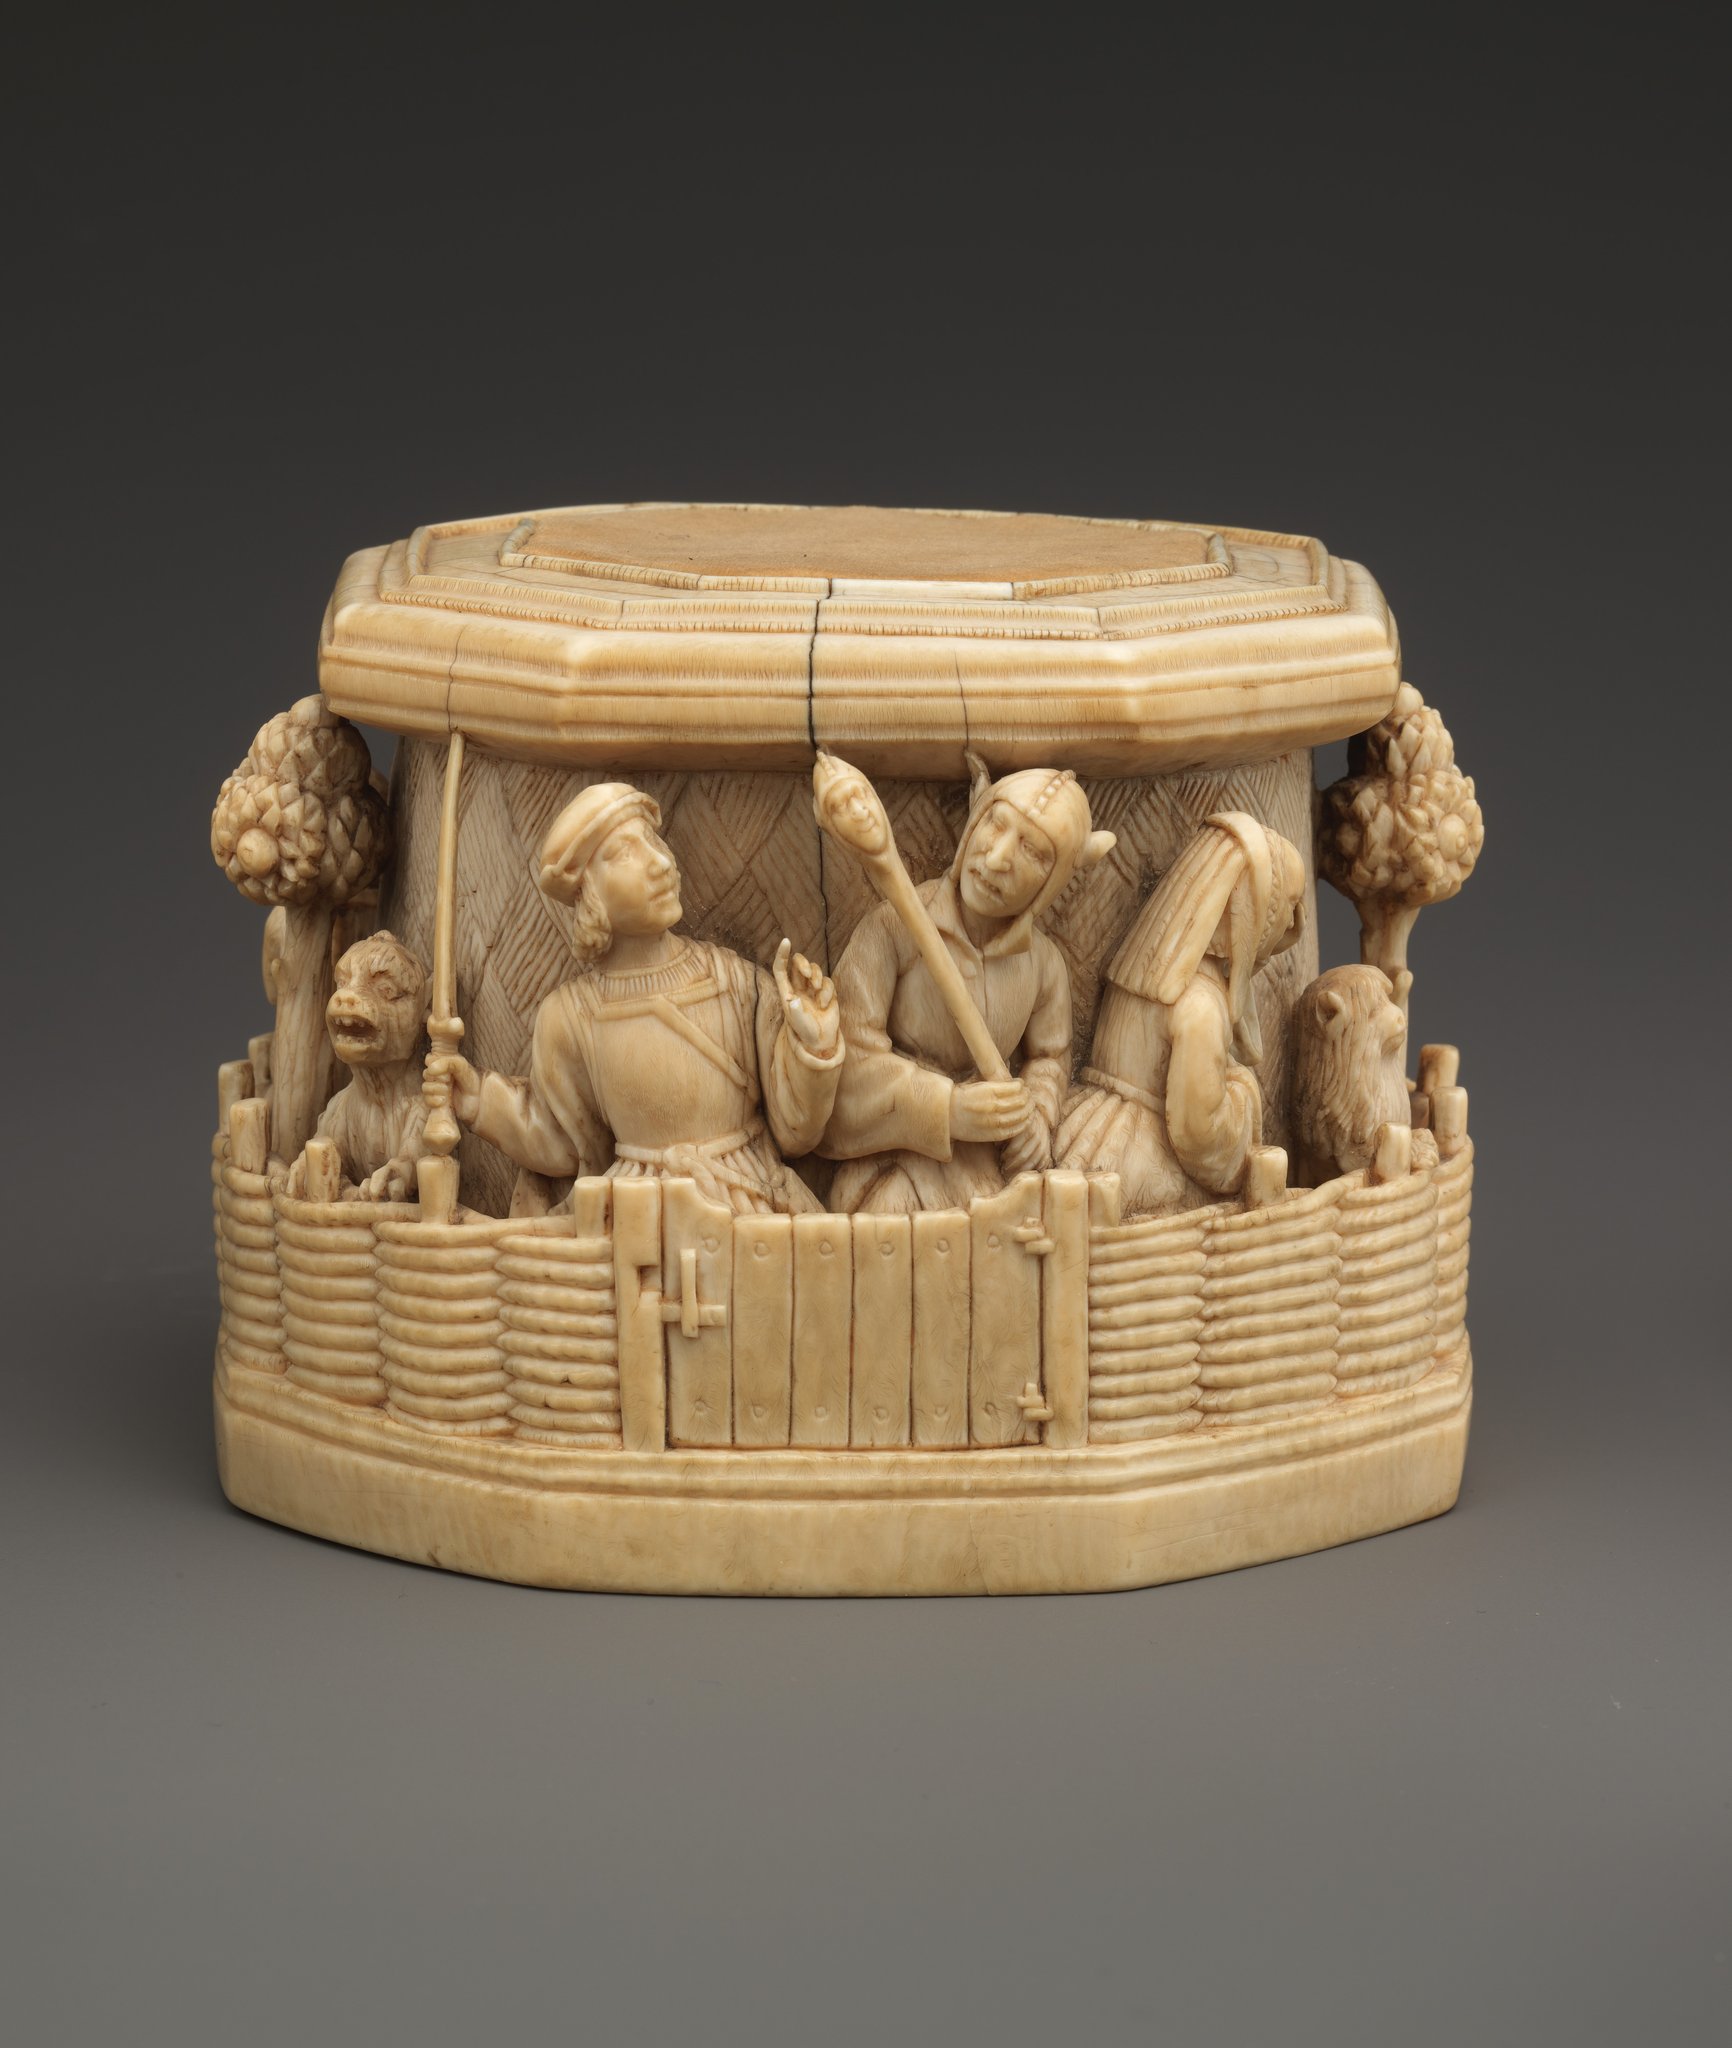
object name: statuette base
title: Base for a Statuette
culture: north french or south netherlandish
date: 1501-1533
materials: ivory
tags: animals,men,women